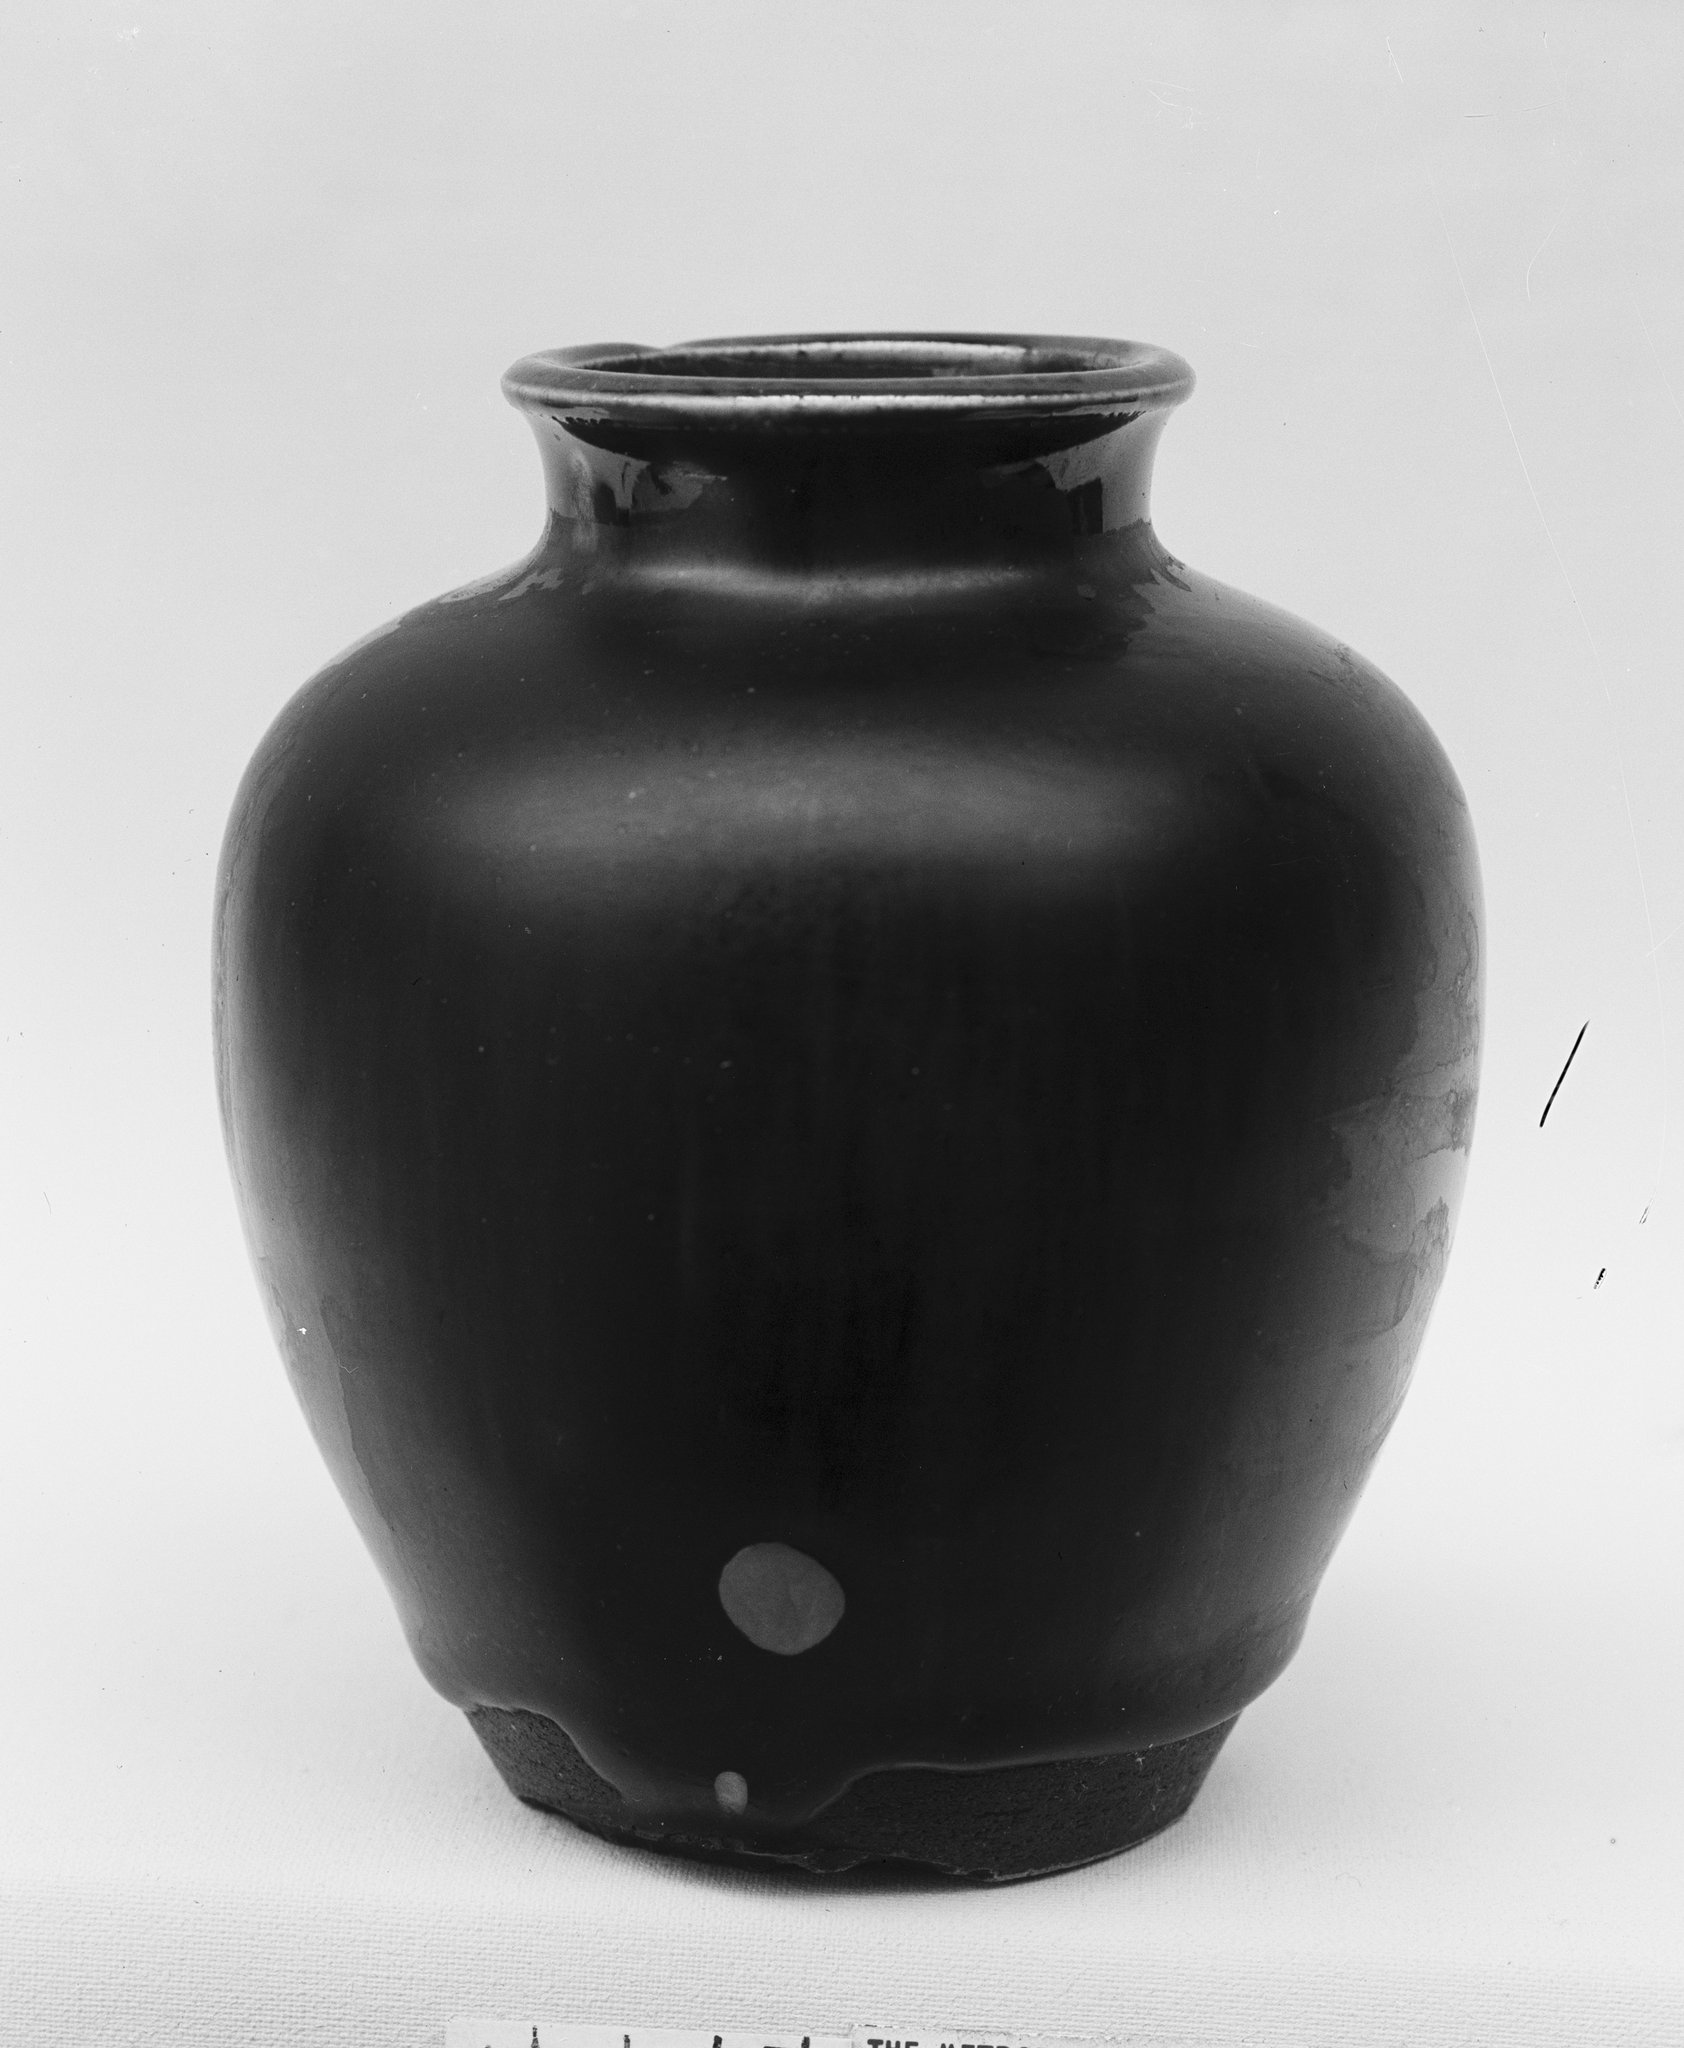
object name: jar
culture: japanese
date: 1701-1800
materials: clay, glaze